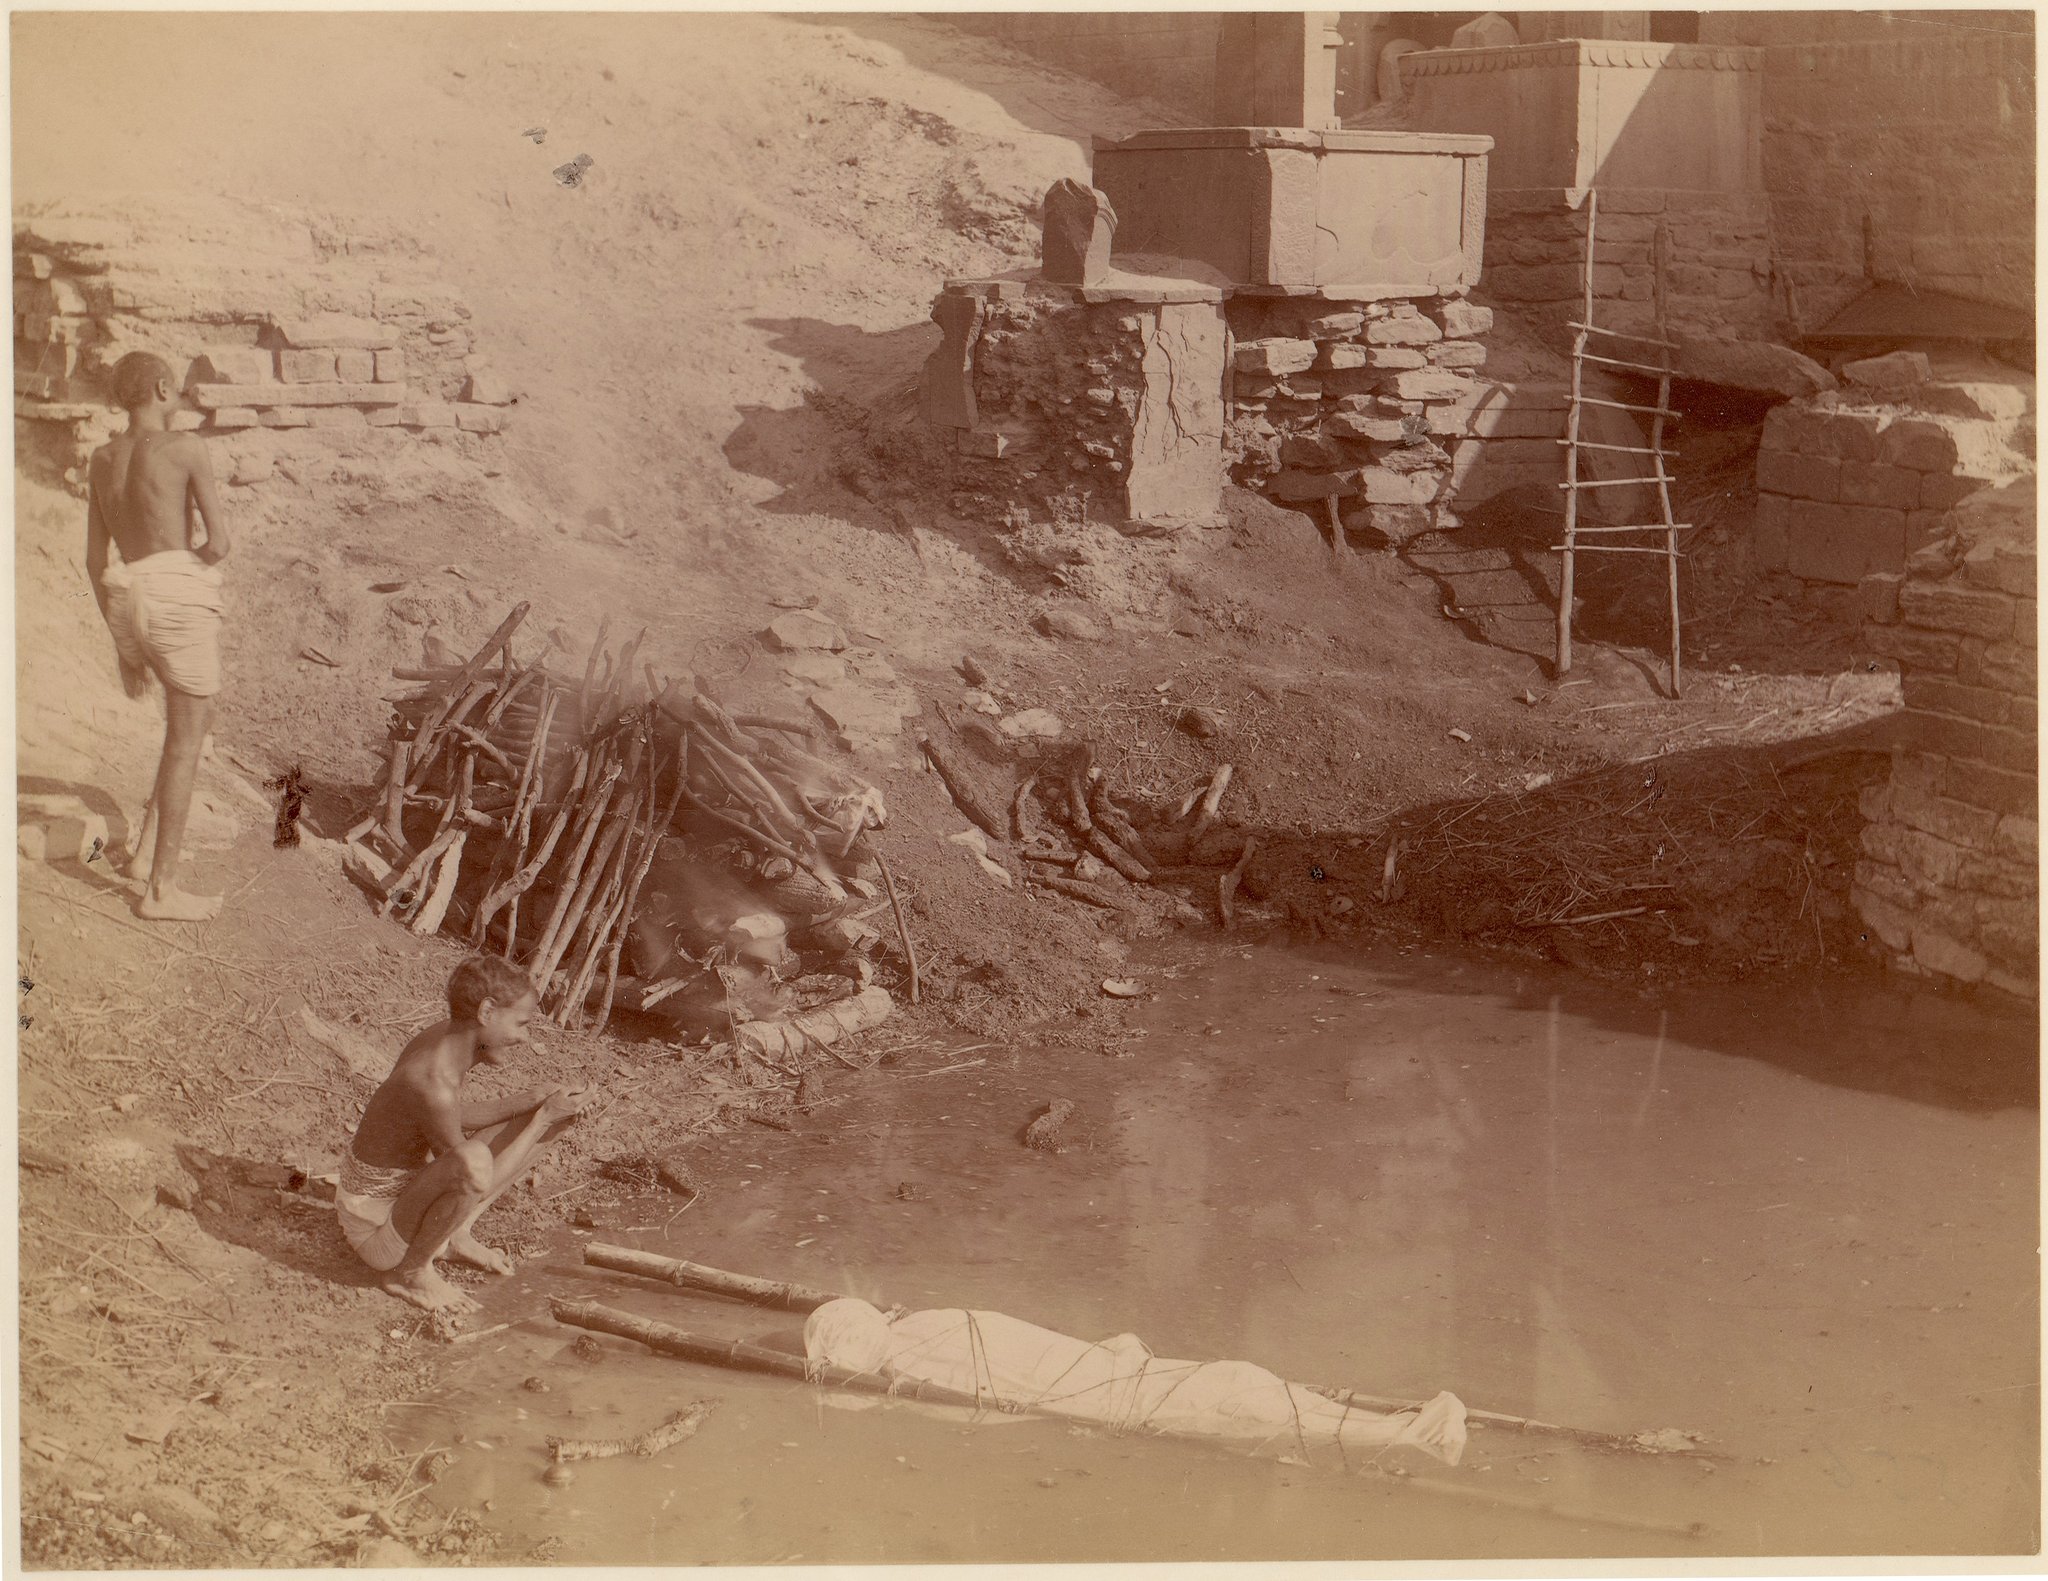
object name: photograph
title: [Cremation Ground at Manikarnika Ghat, Varanasi, India]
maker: Anonymous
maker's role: artist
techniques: albumen silver print, glass negative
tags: corpses,men,death